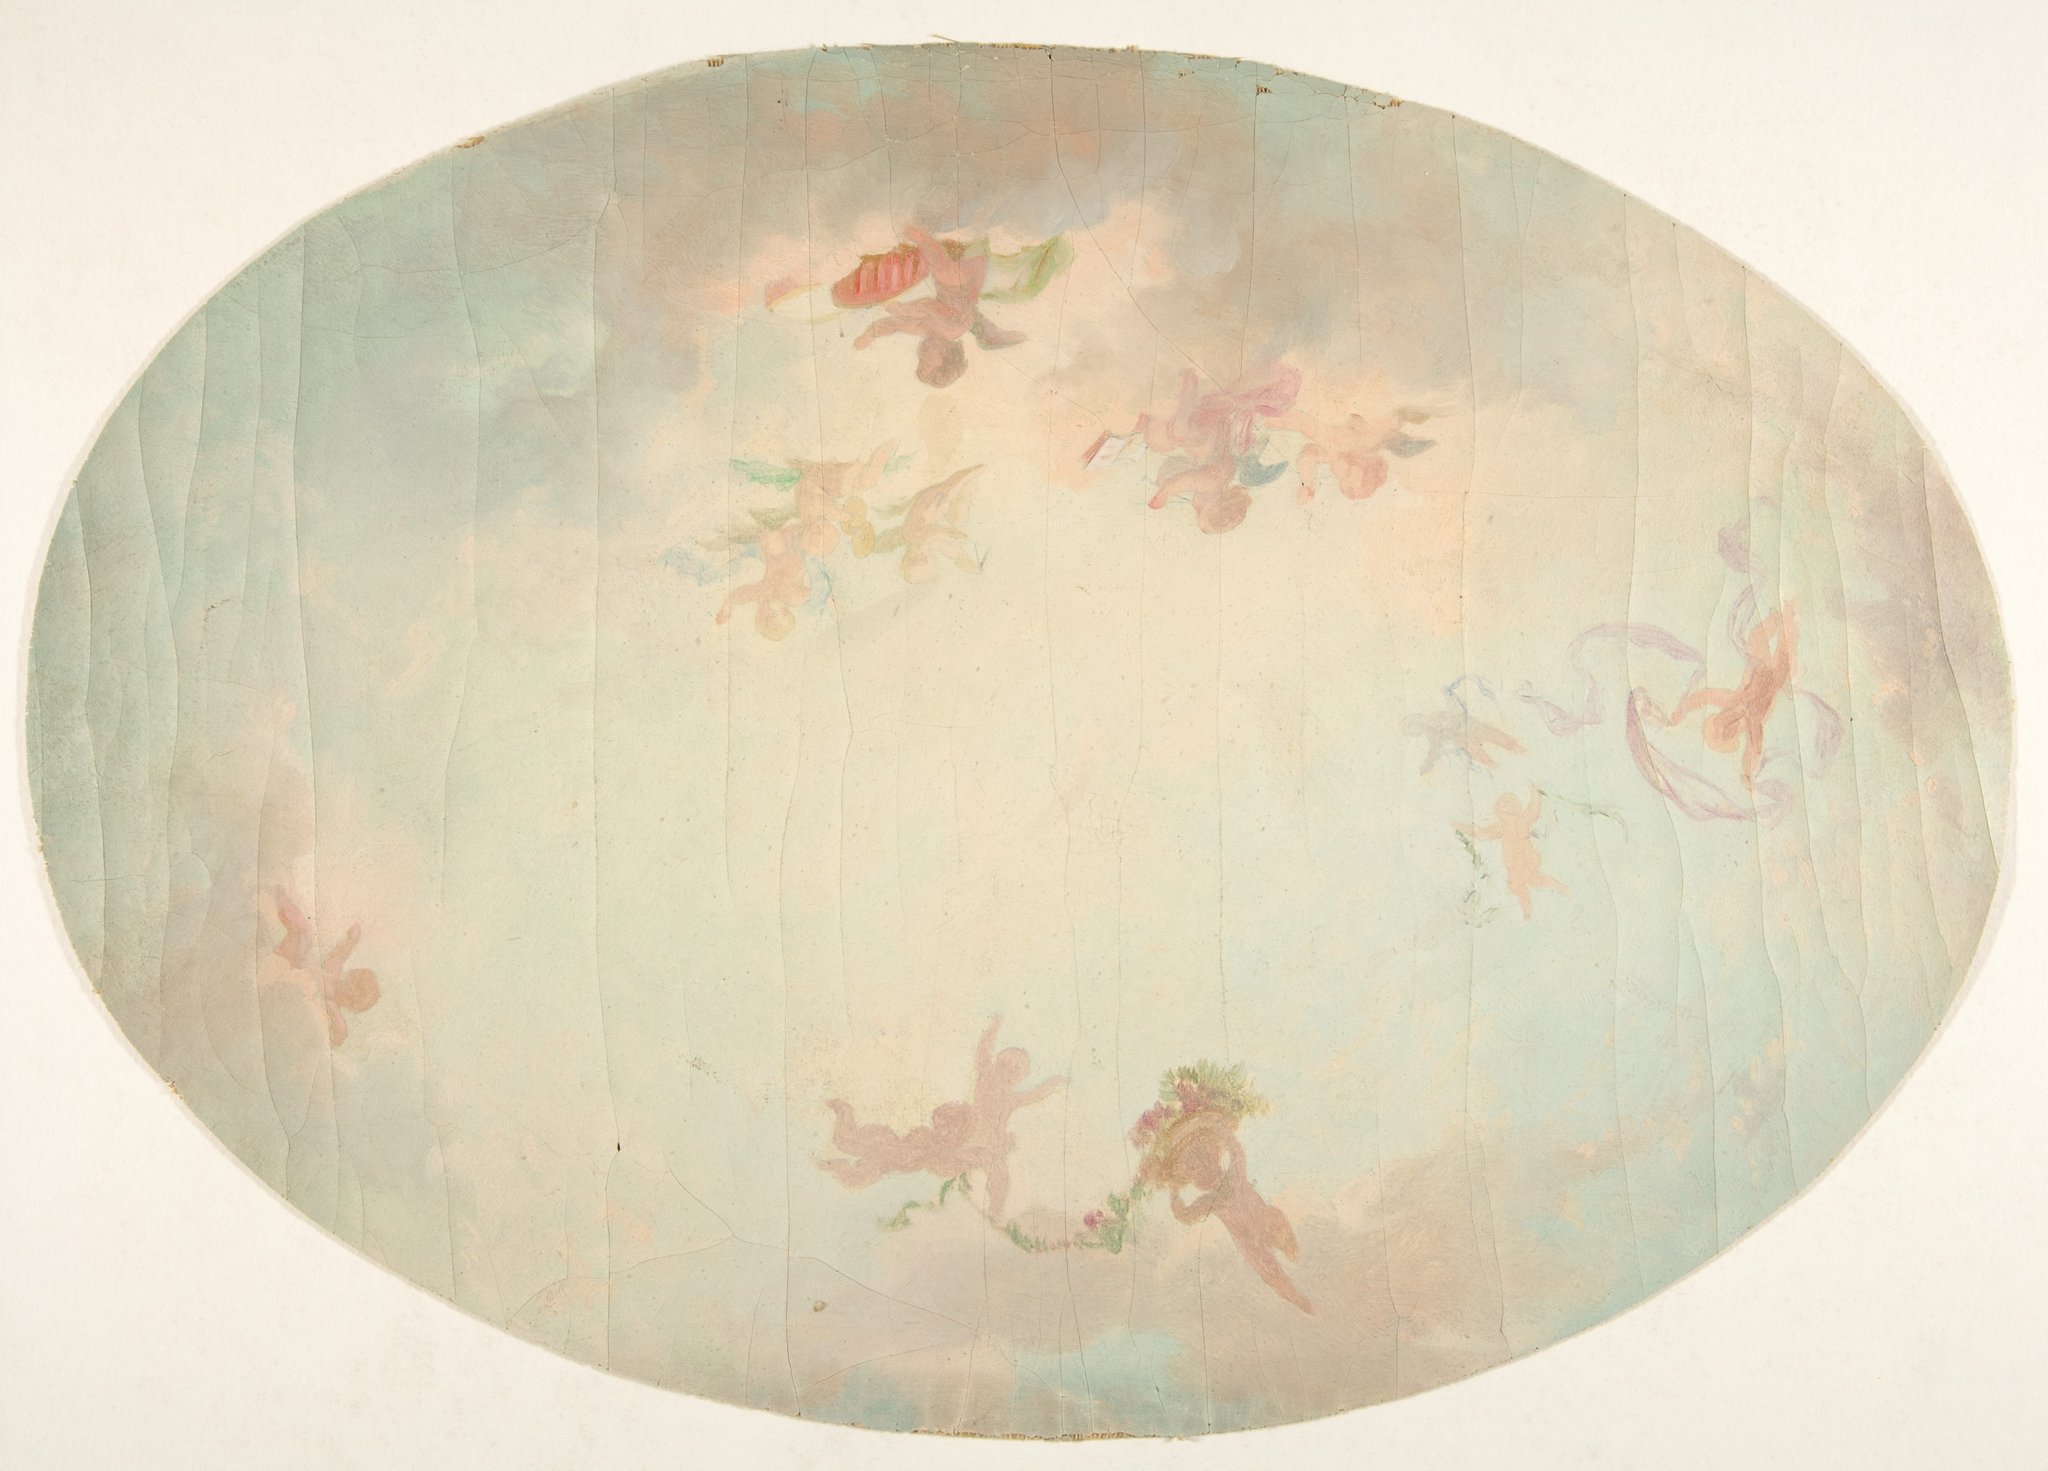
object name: drawing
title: Oval design for a ceiling painted with putti in clouds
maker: jules-edmond-charles lachaise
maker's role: artist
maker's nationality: french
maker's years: 1897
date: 1851-1900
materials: canvas, oil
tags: putti,clouds,ceilings